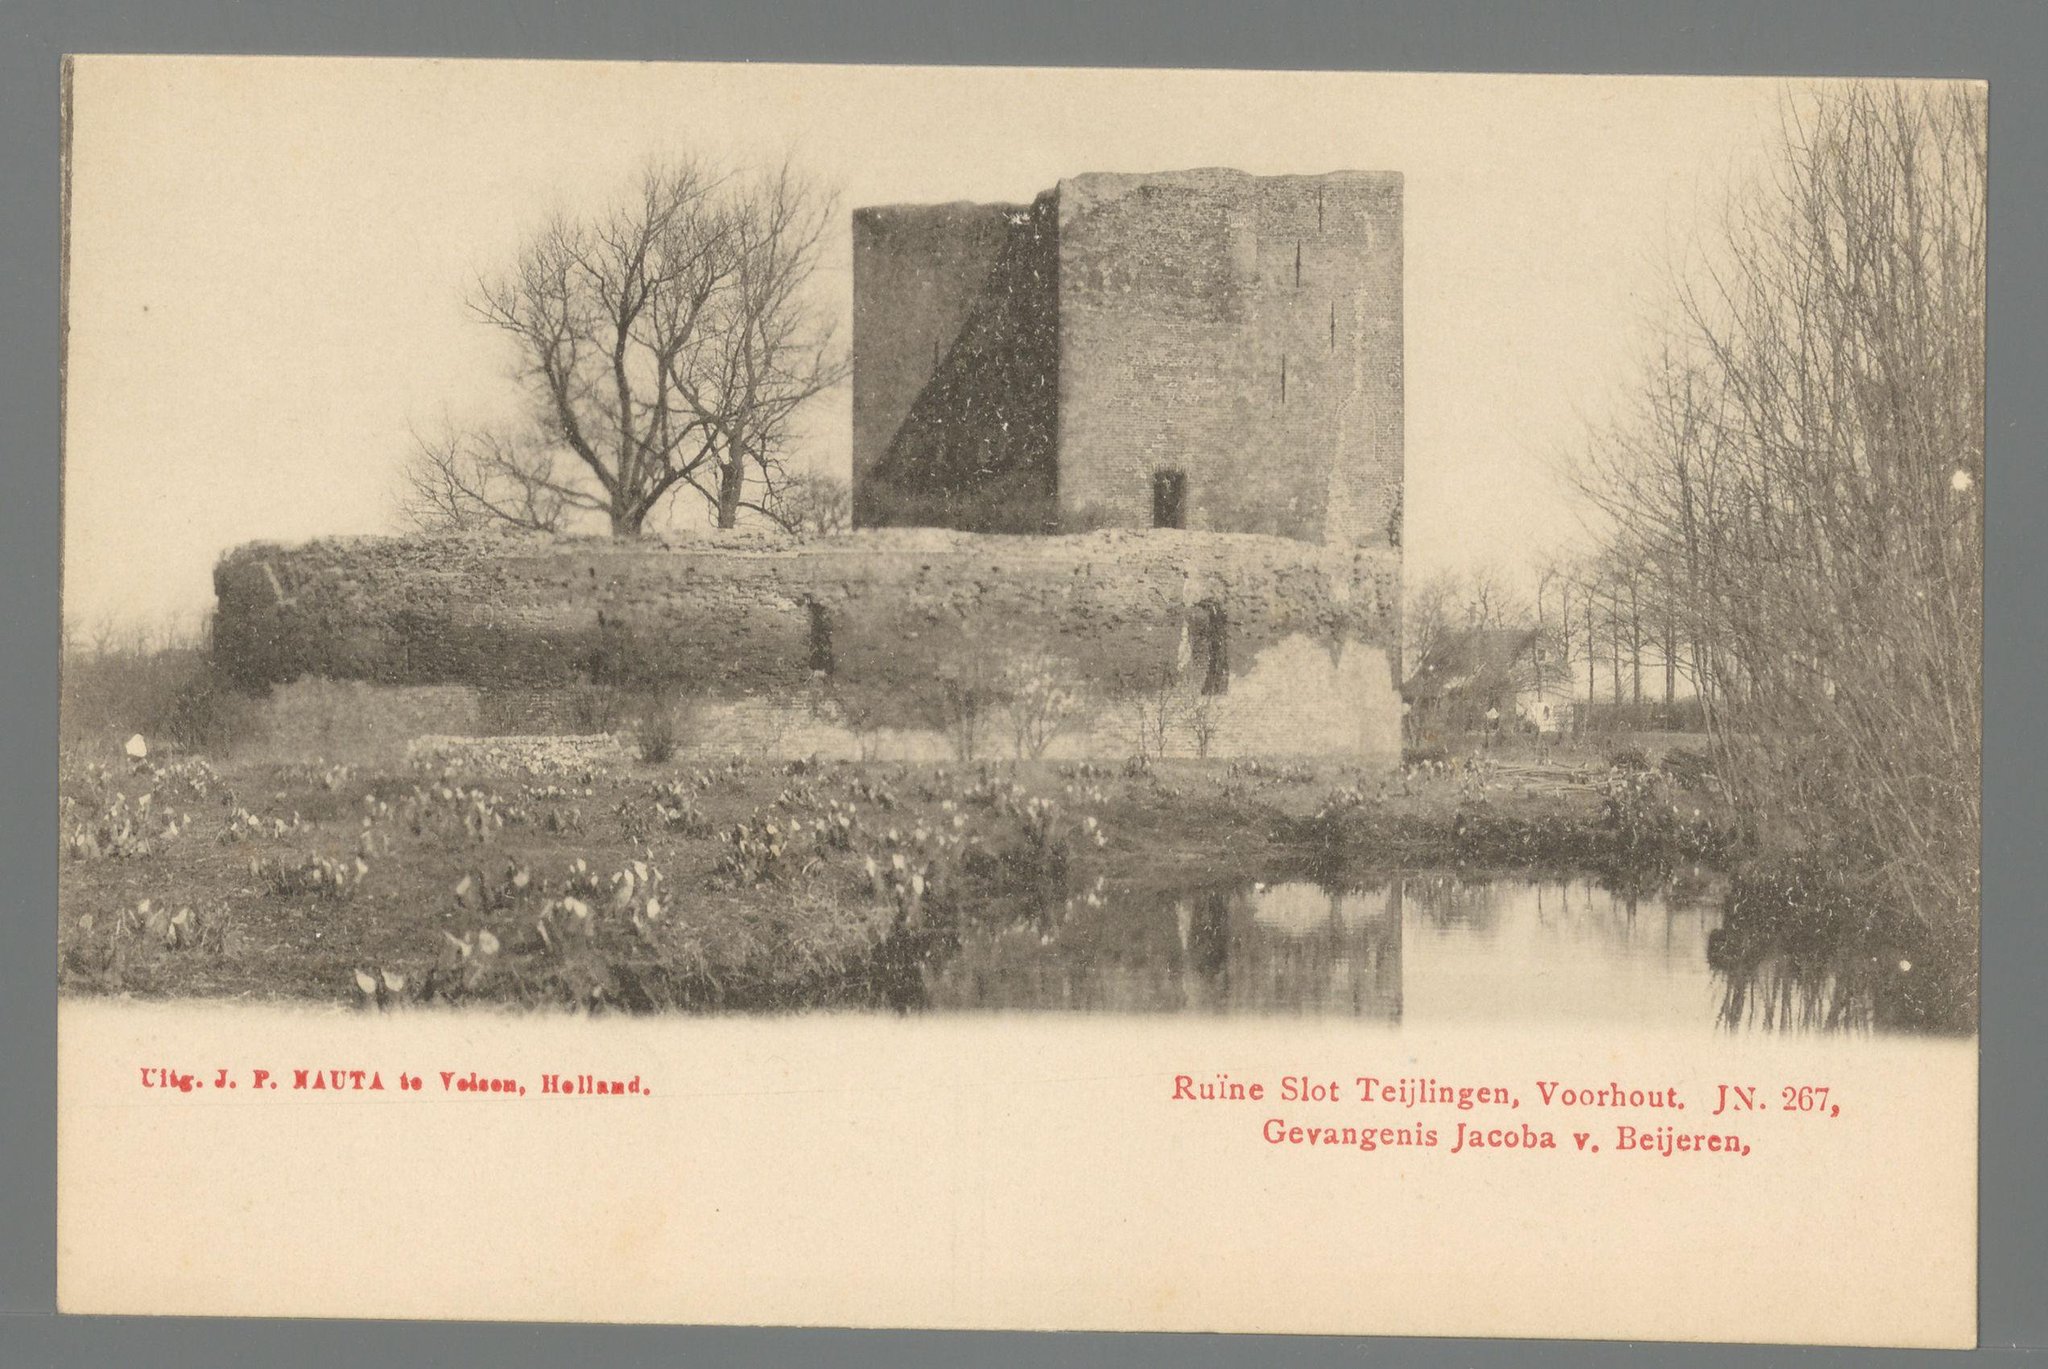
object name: photomechanical print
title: Ruïne Slot Teijlingen, Voorhout. Gevangenis Jacoba v. Beijeren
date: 1897-1905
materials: cardboard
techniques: photograph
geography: voorhout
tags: prison, jail, ruin of a dwelling, house, castle, etc.